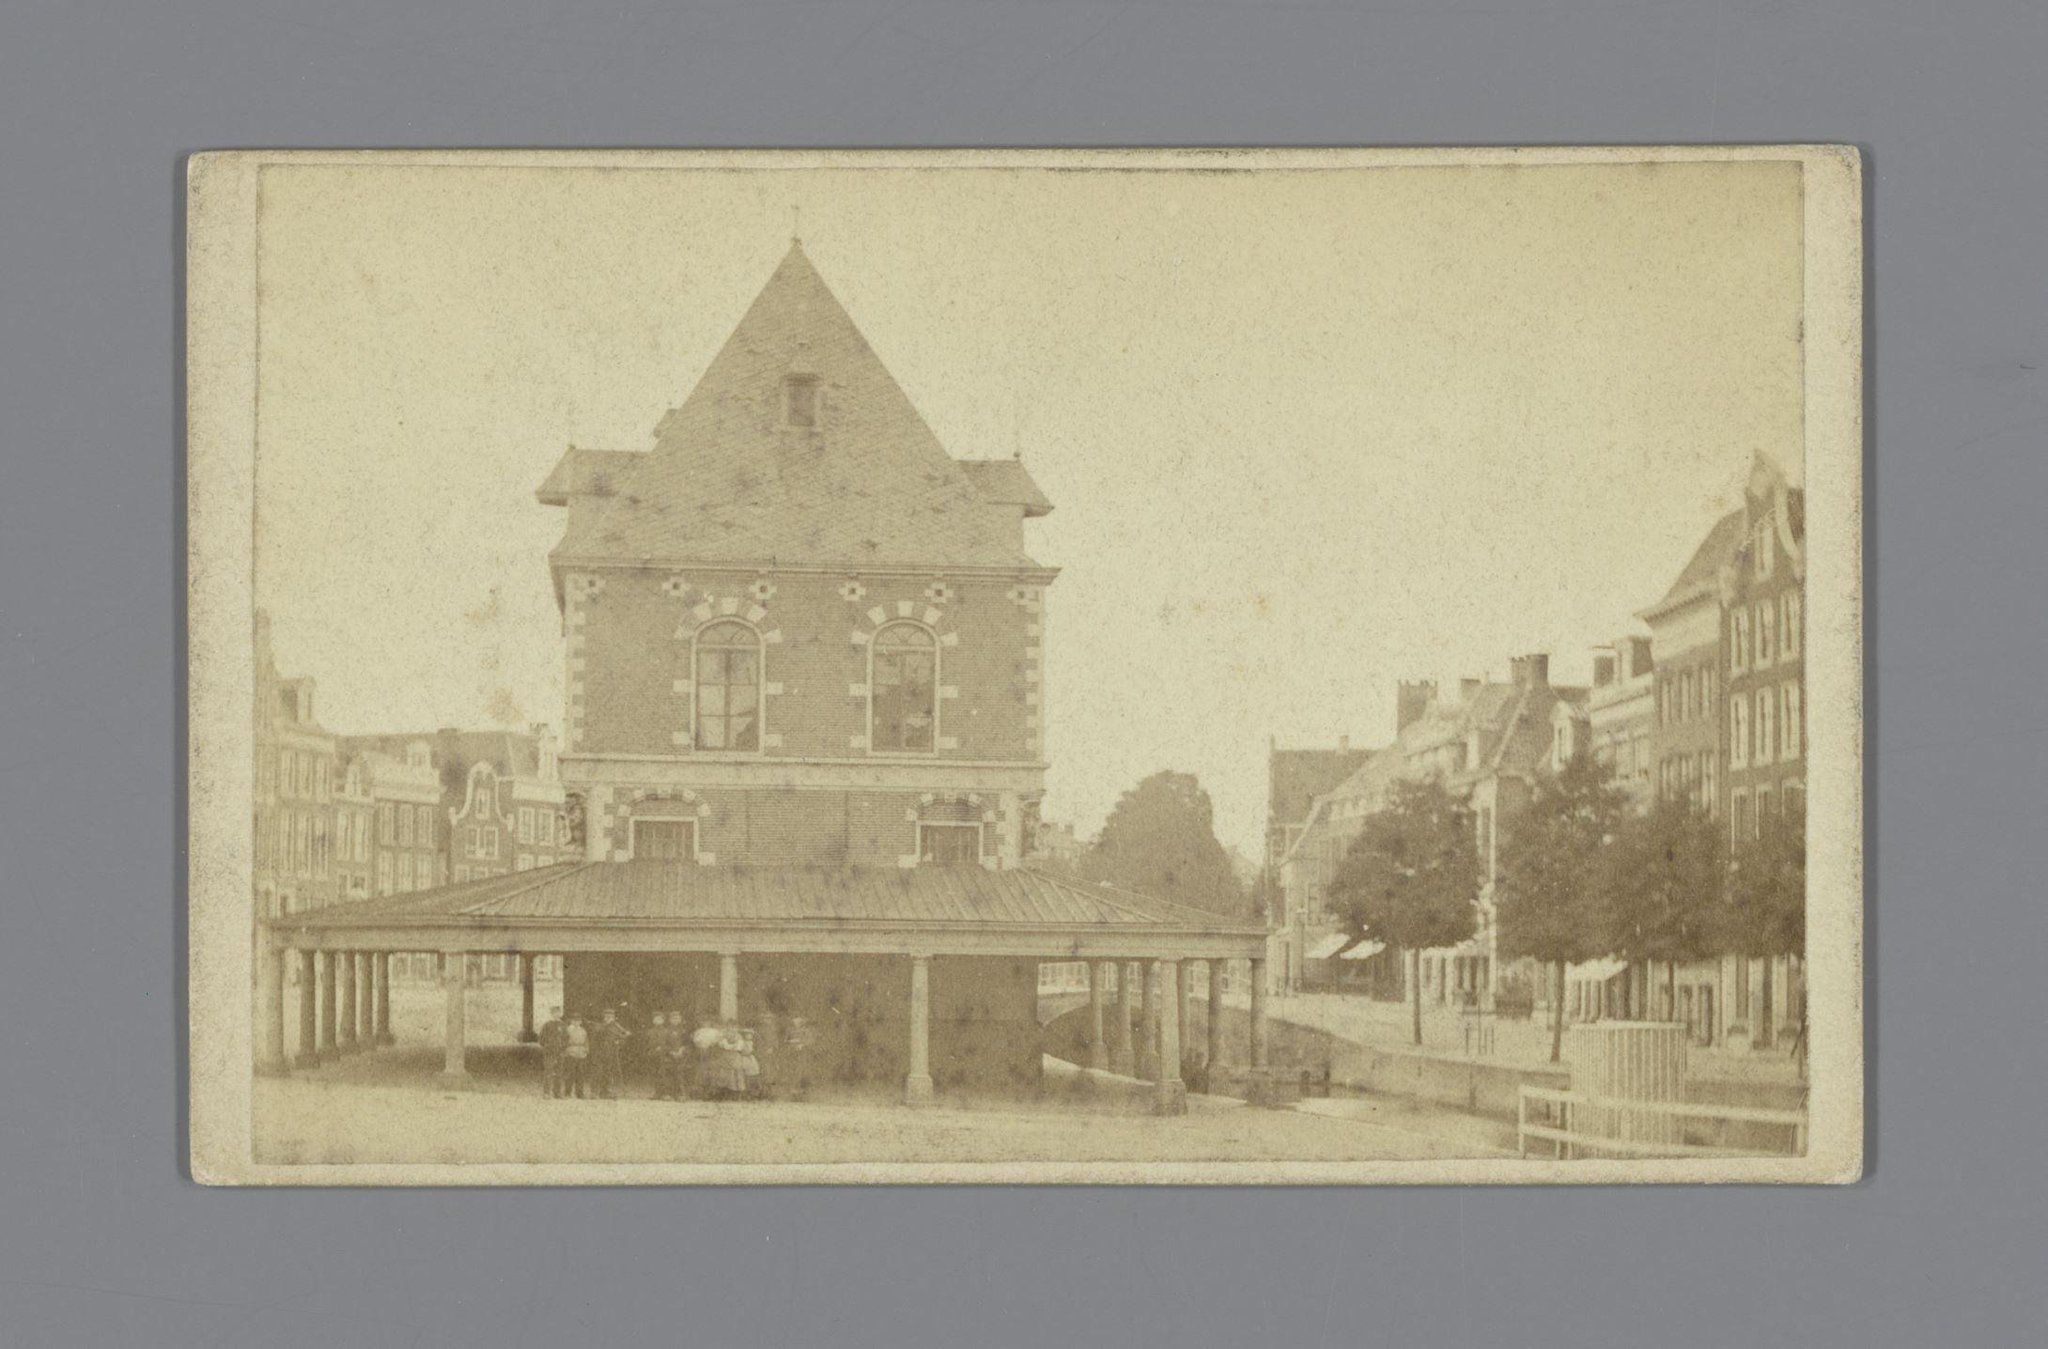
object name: carte de visite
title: Gezicht op de Waag te Leeuwarden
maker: pieter oosterhuis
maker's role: draughtsman, print maker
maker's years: 1816-1885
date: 1860-1885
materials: cardboard, photographic support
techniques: albumen print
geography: leeuwarden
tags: weigh-house, street (+ city(-scape) with figures, staffage)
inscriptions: retailer's mark: ‘W. EEKHOFF/ BOEKHANDEL/ LEEUWARDEN’, inscription: ‘Stads-Waag no. 2’, inscription: ‘PHOT. P. OOSTERHUIS, AMSTERDAM.’